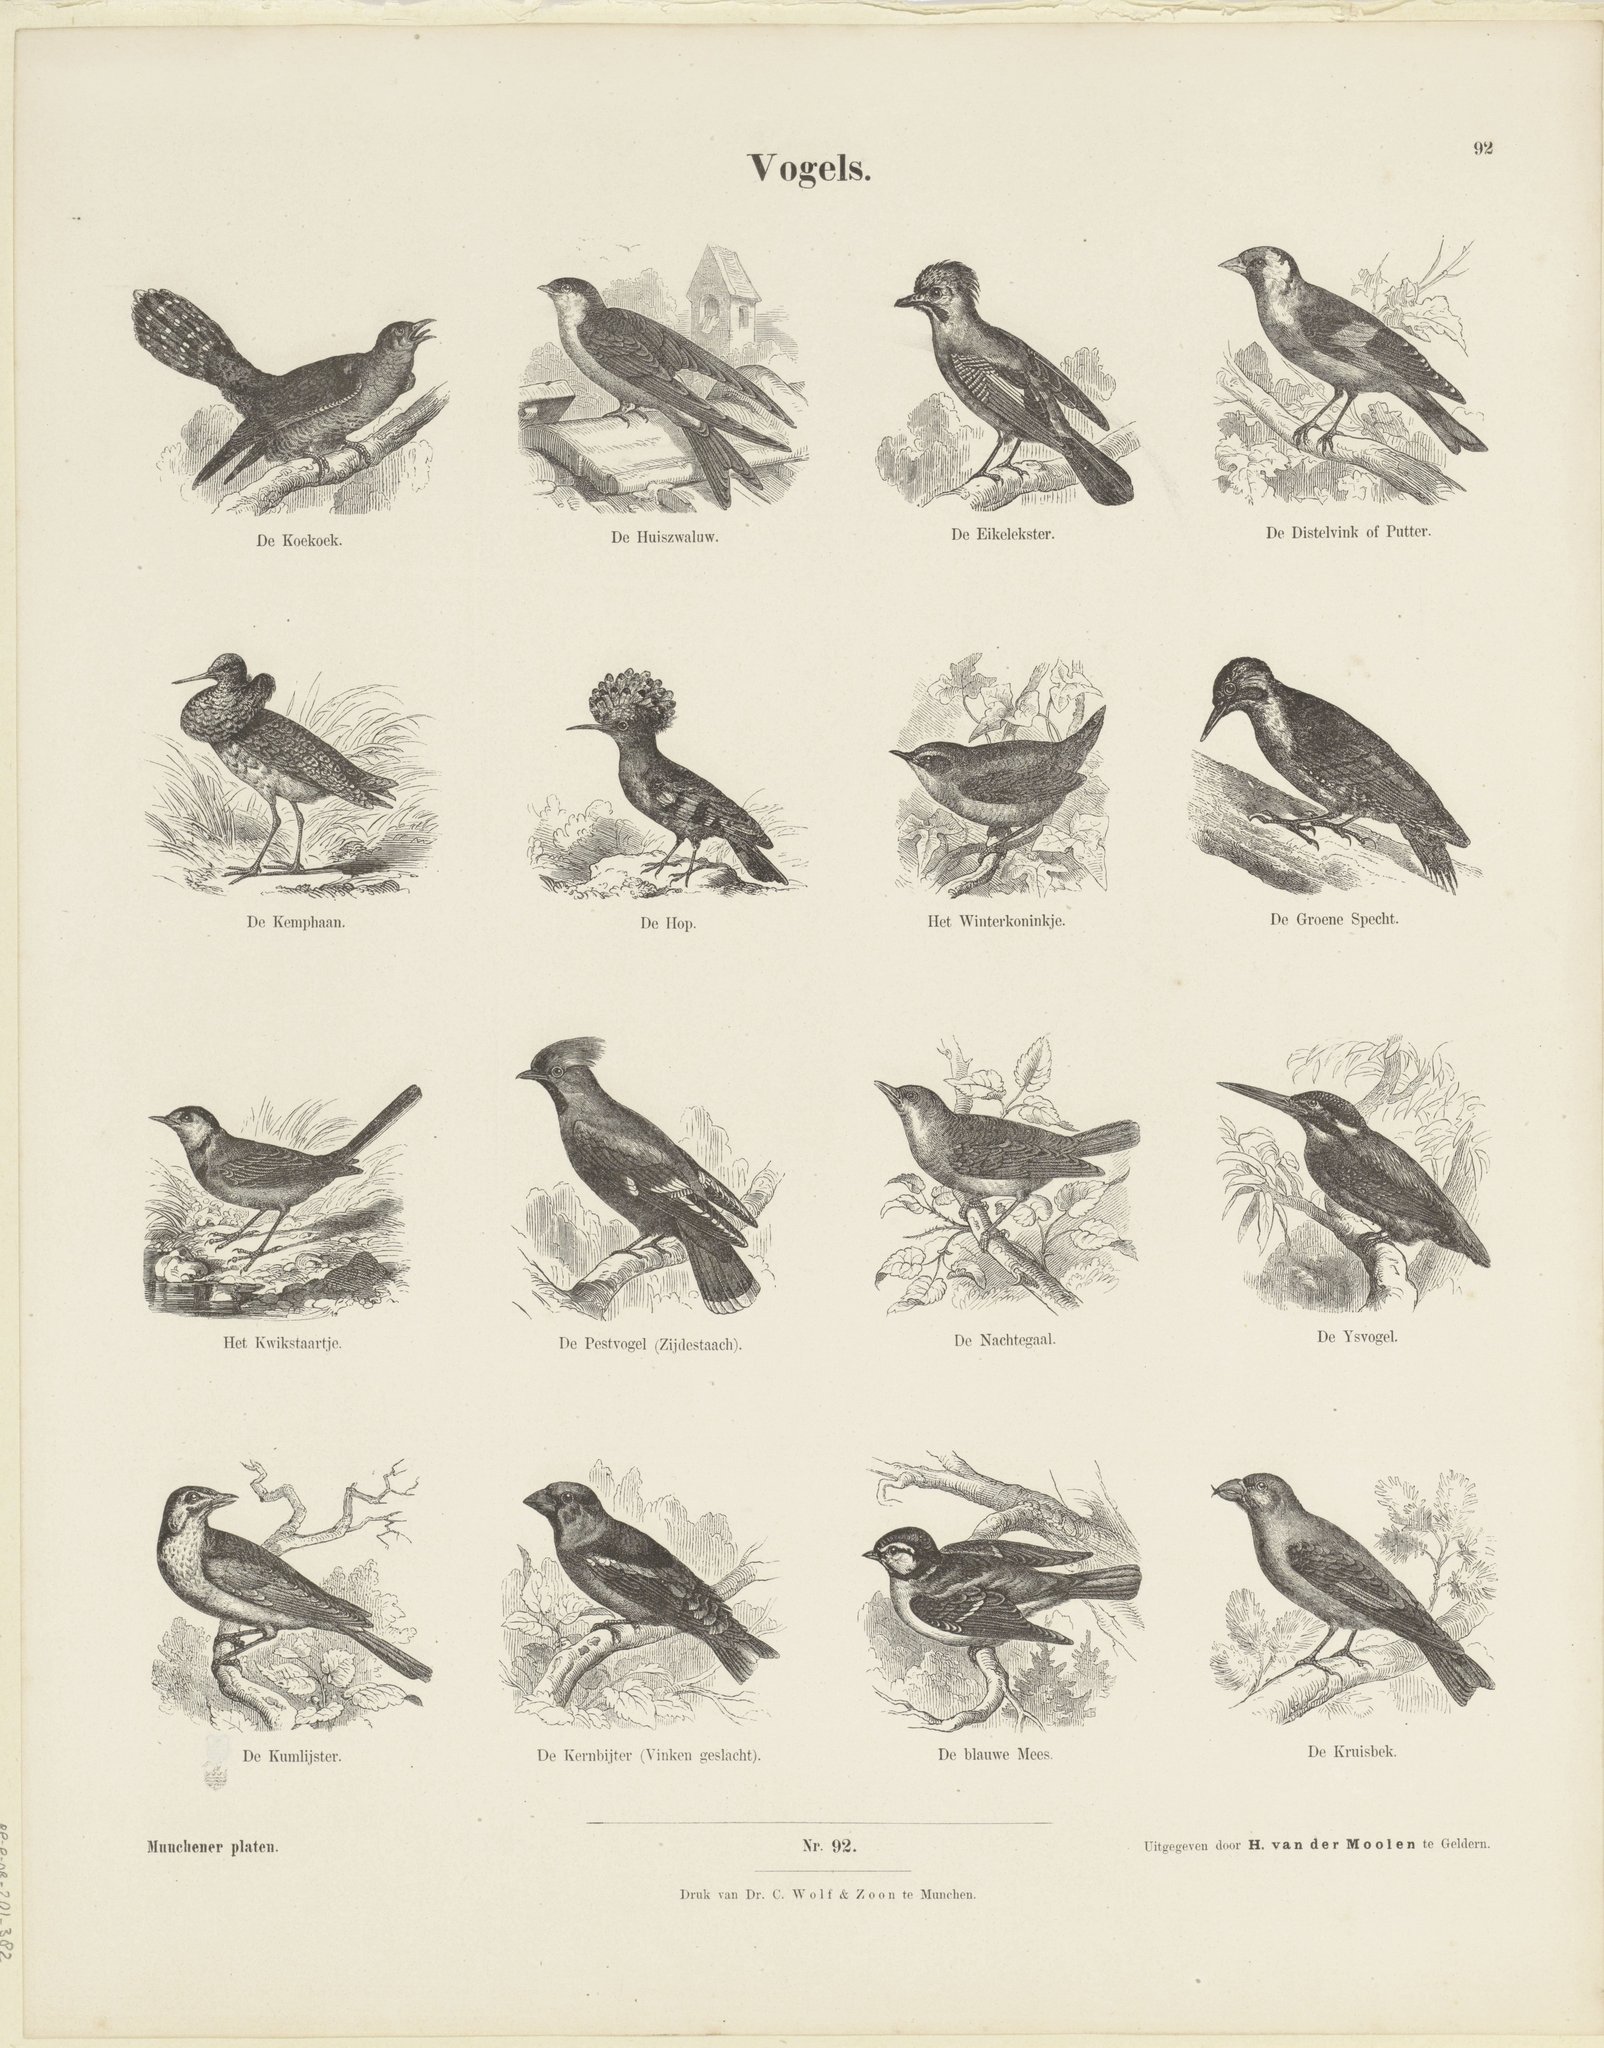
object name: popular print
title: Munchener platen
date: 1820-1843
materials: paper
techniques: letterpress printing, engraving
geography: geldern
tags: birds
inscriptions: collector's mark: Lugt 2760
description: Blad met 16 voorstellingen van vogels, waaronder een koekoek, een puttertje, een kemphaan, een ijsvogel, een kwikstaartje en een kruisbek. Onder de afbeeldingen een onderschrift. Genummerd midden onder: Nro. 92. Genummerd rechtsboven: 92.